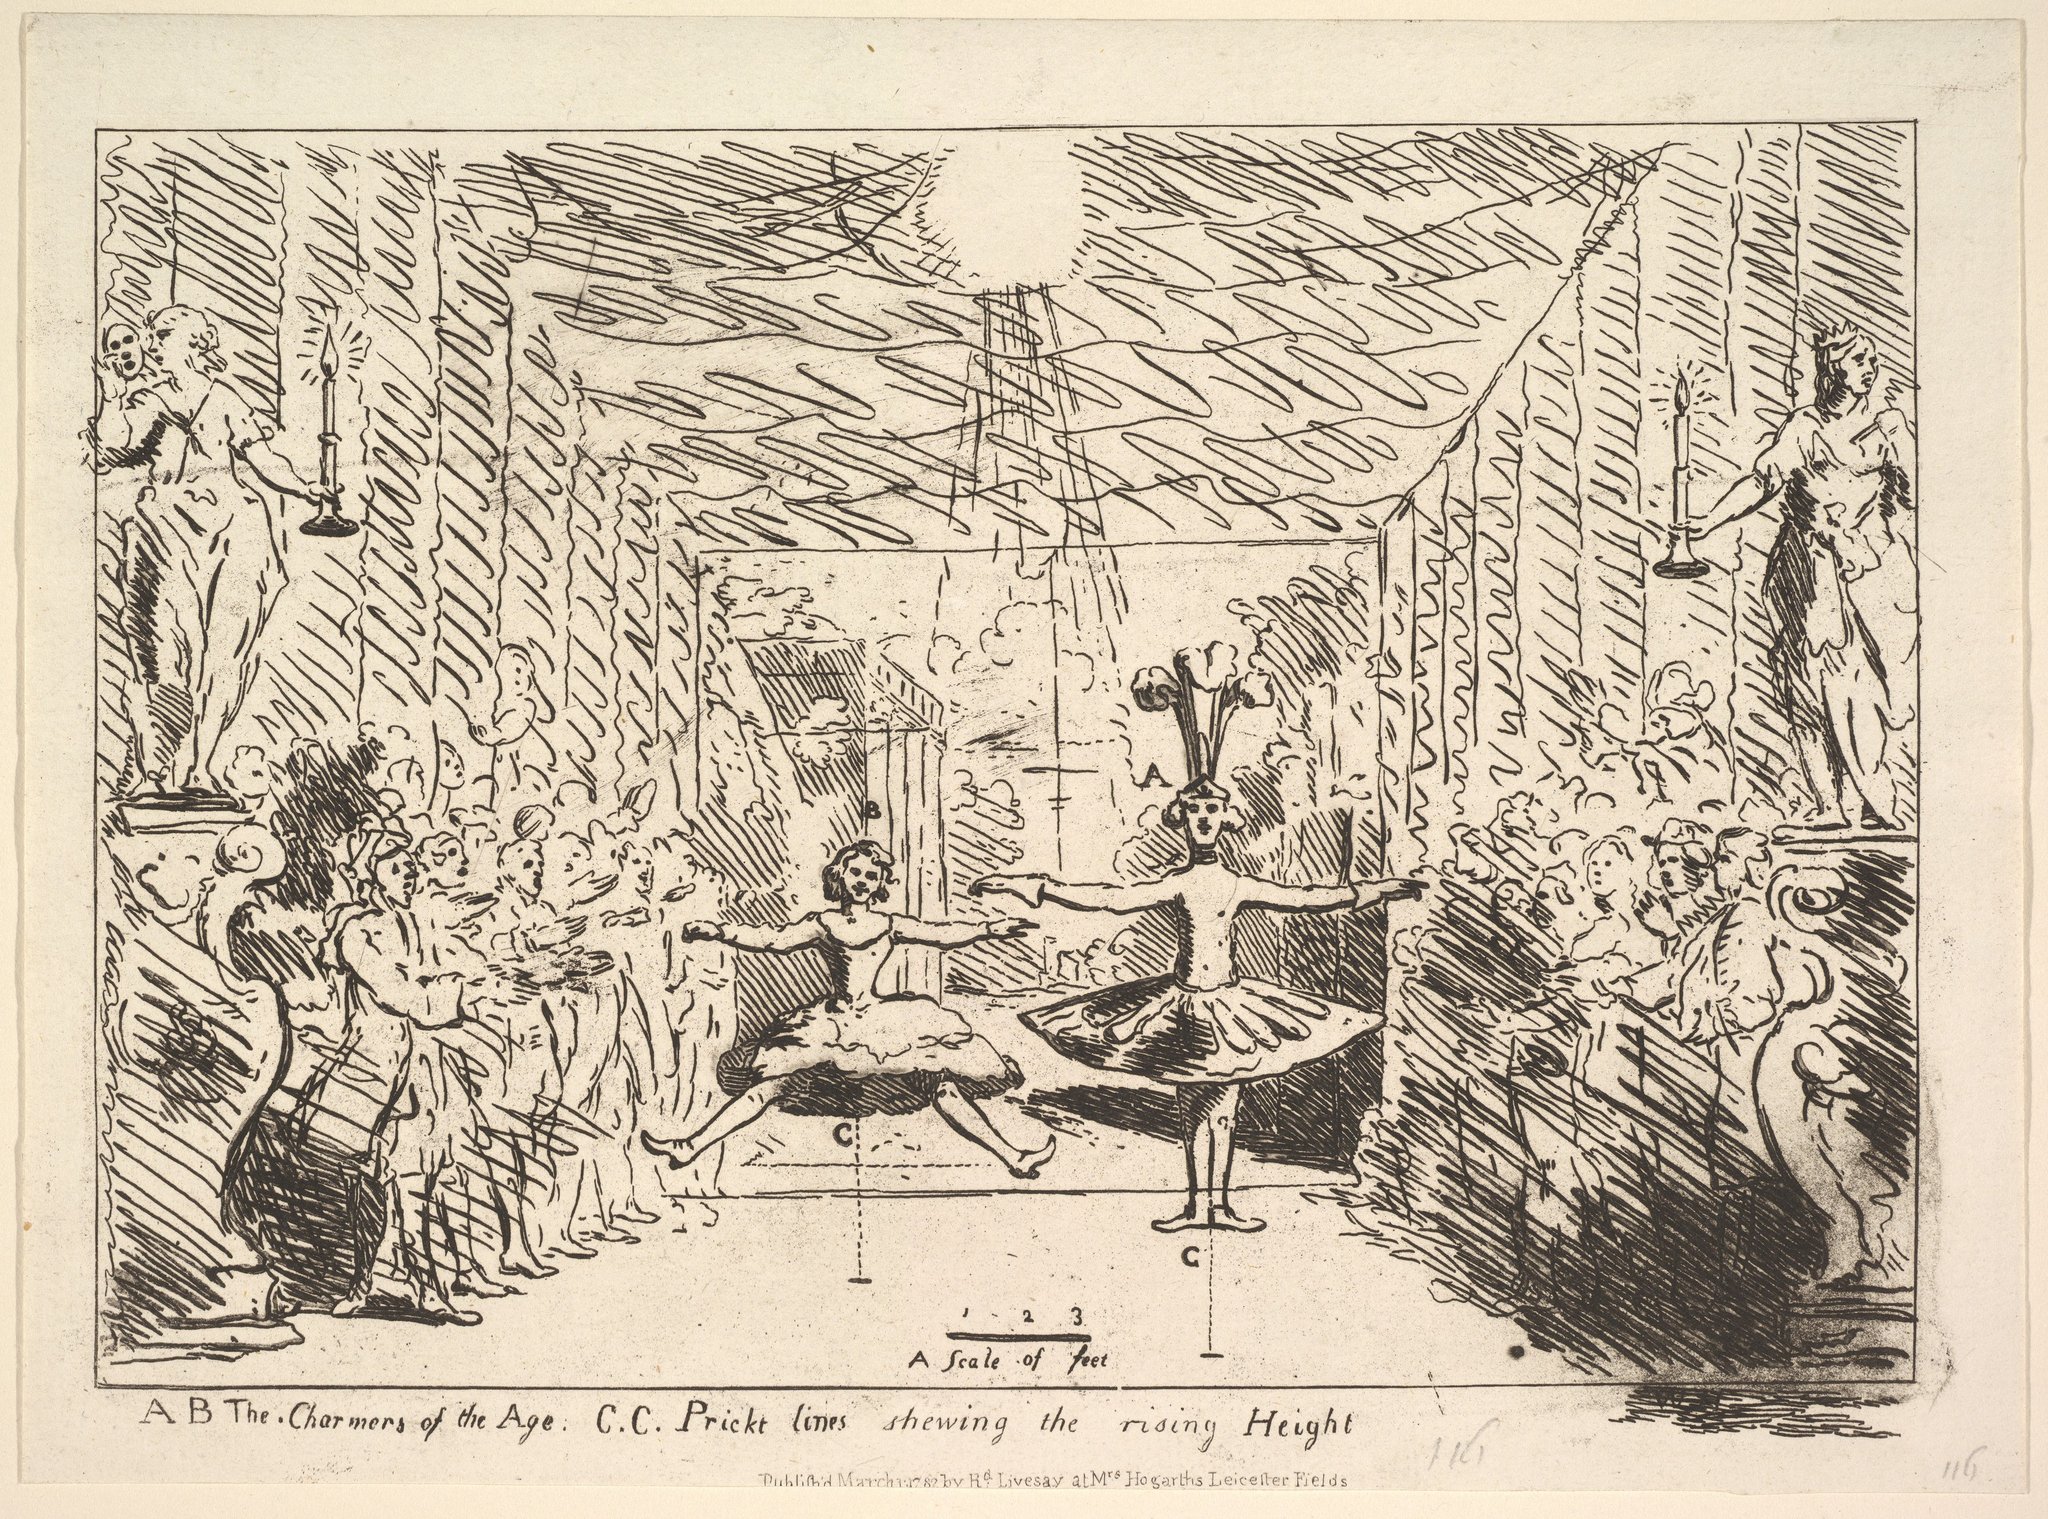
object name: print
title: The Charmers of the Age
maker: richard livesay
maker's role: publisher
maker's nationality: british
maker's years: 1750-1826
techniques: etching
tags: men,women,spectators,dancing